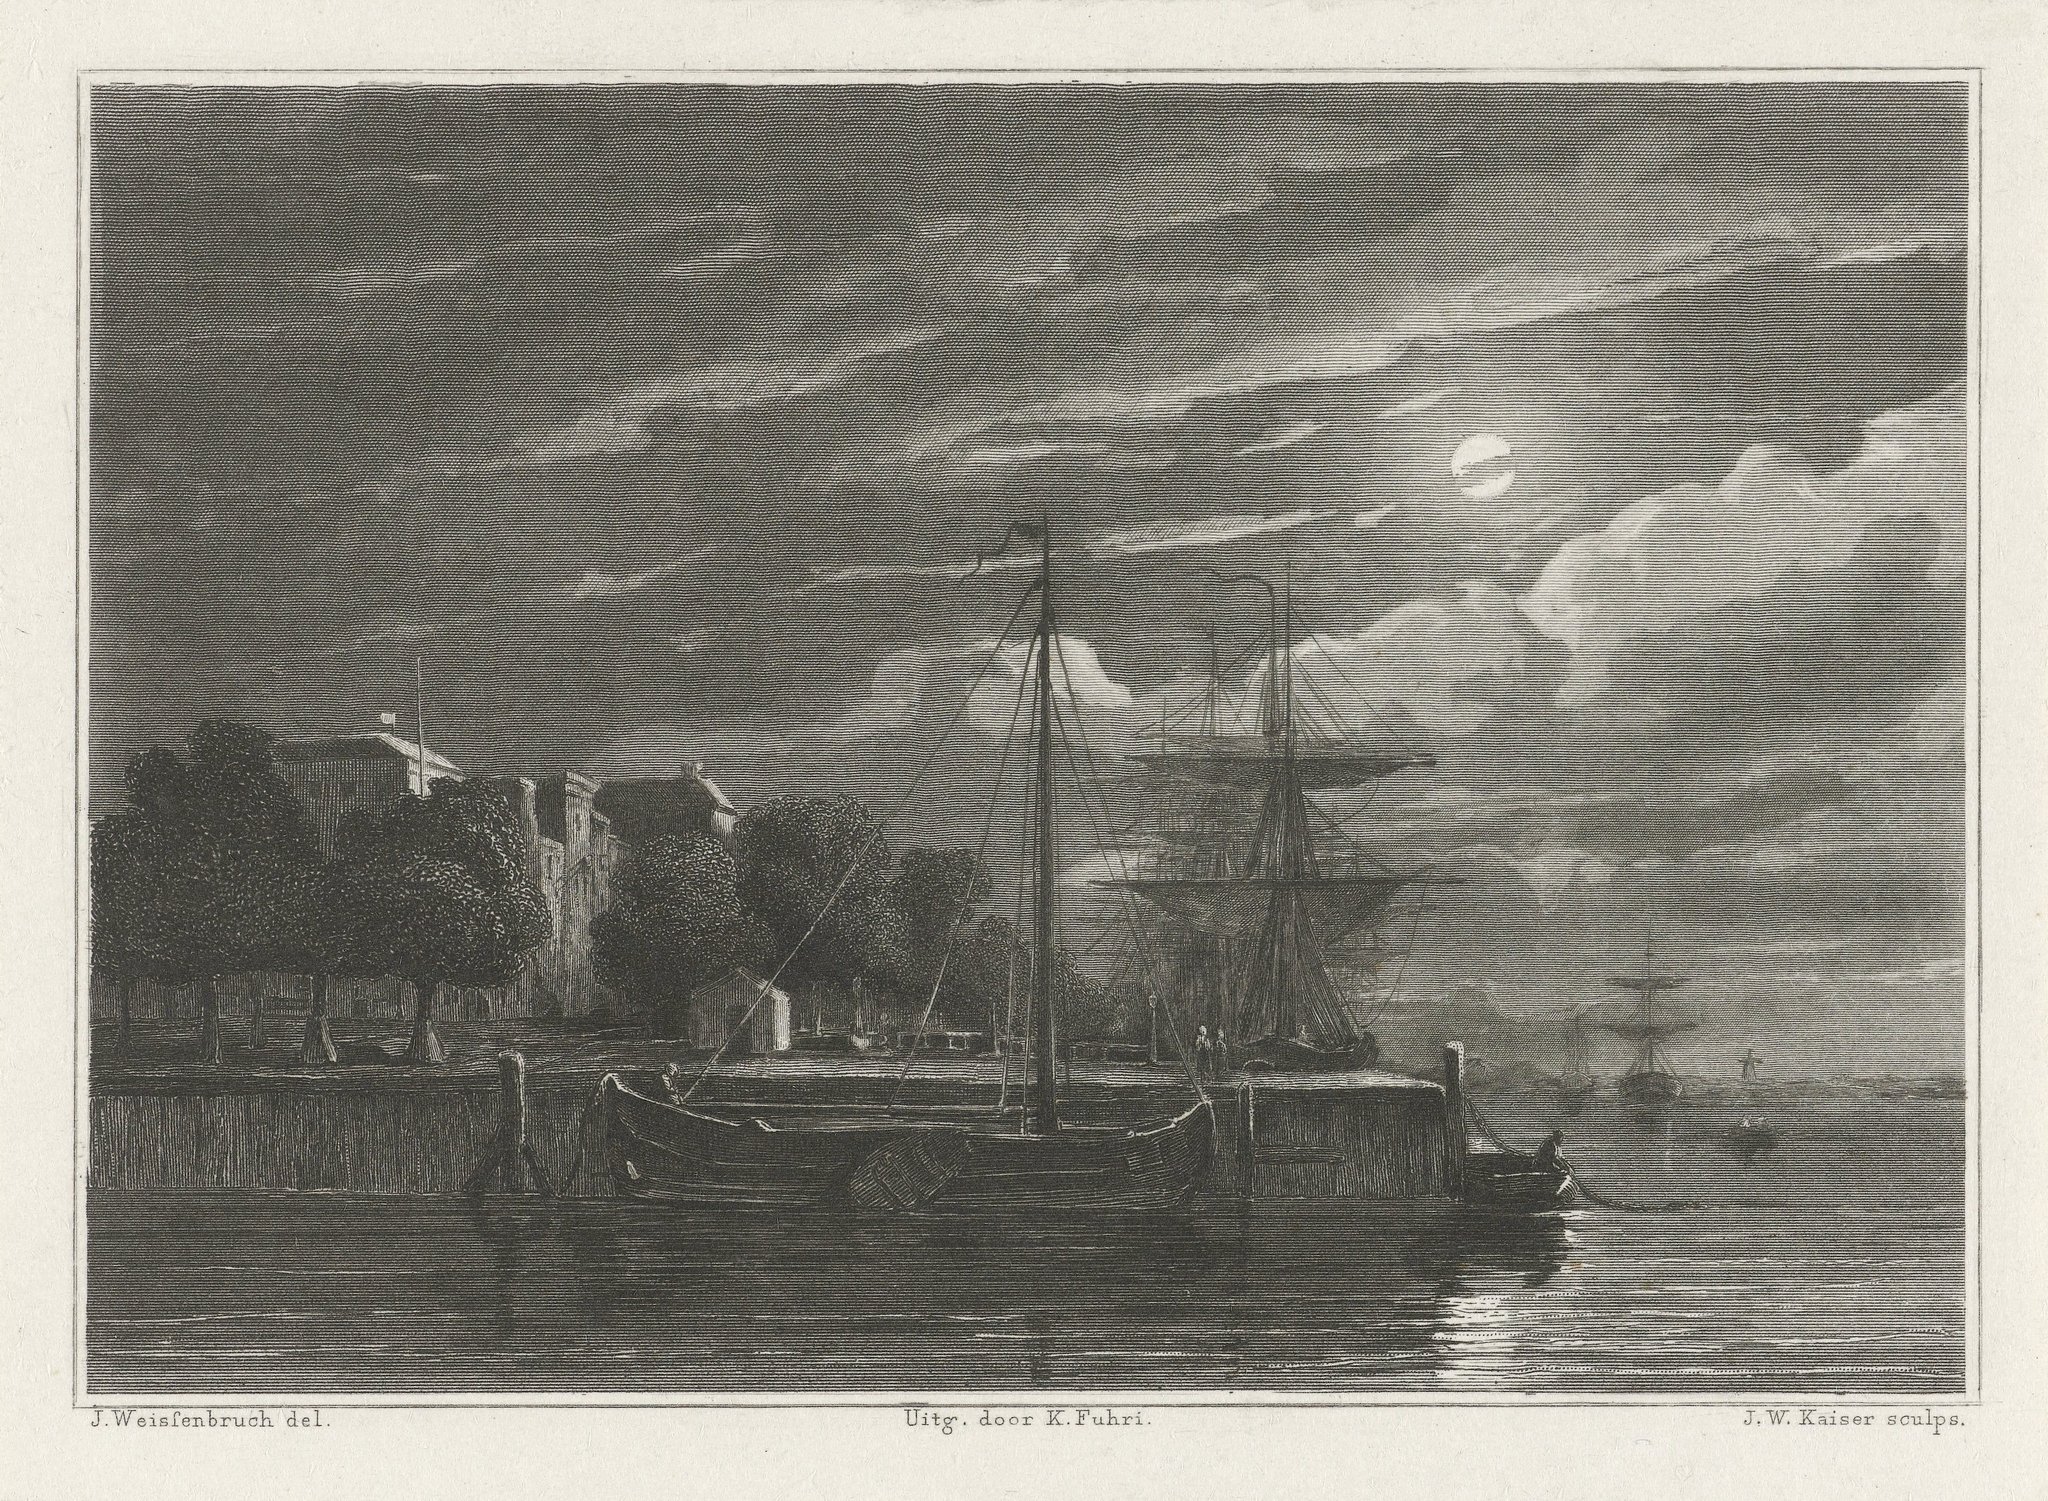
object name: print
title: Riviergezicht bij nacht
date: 1823-1900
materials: paper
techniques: etching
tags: full moon, sailing-ship, sailing-boat, windmill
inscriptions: collector's mark: Lugt 2228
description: Riviergezicht bij nacht met op de voorgrond een boot die aan de kade ligt en op de achtergrond een aantal zeilschepen.